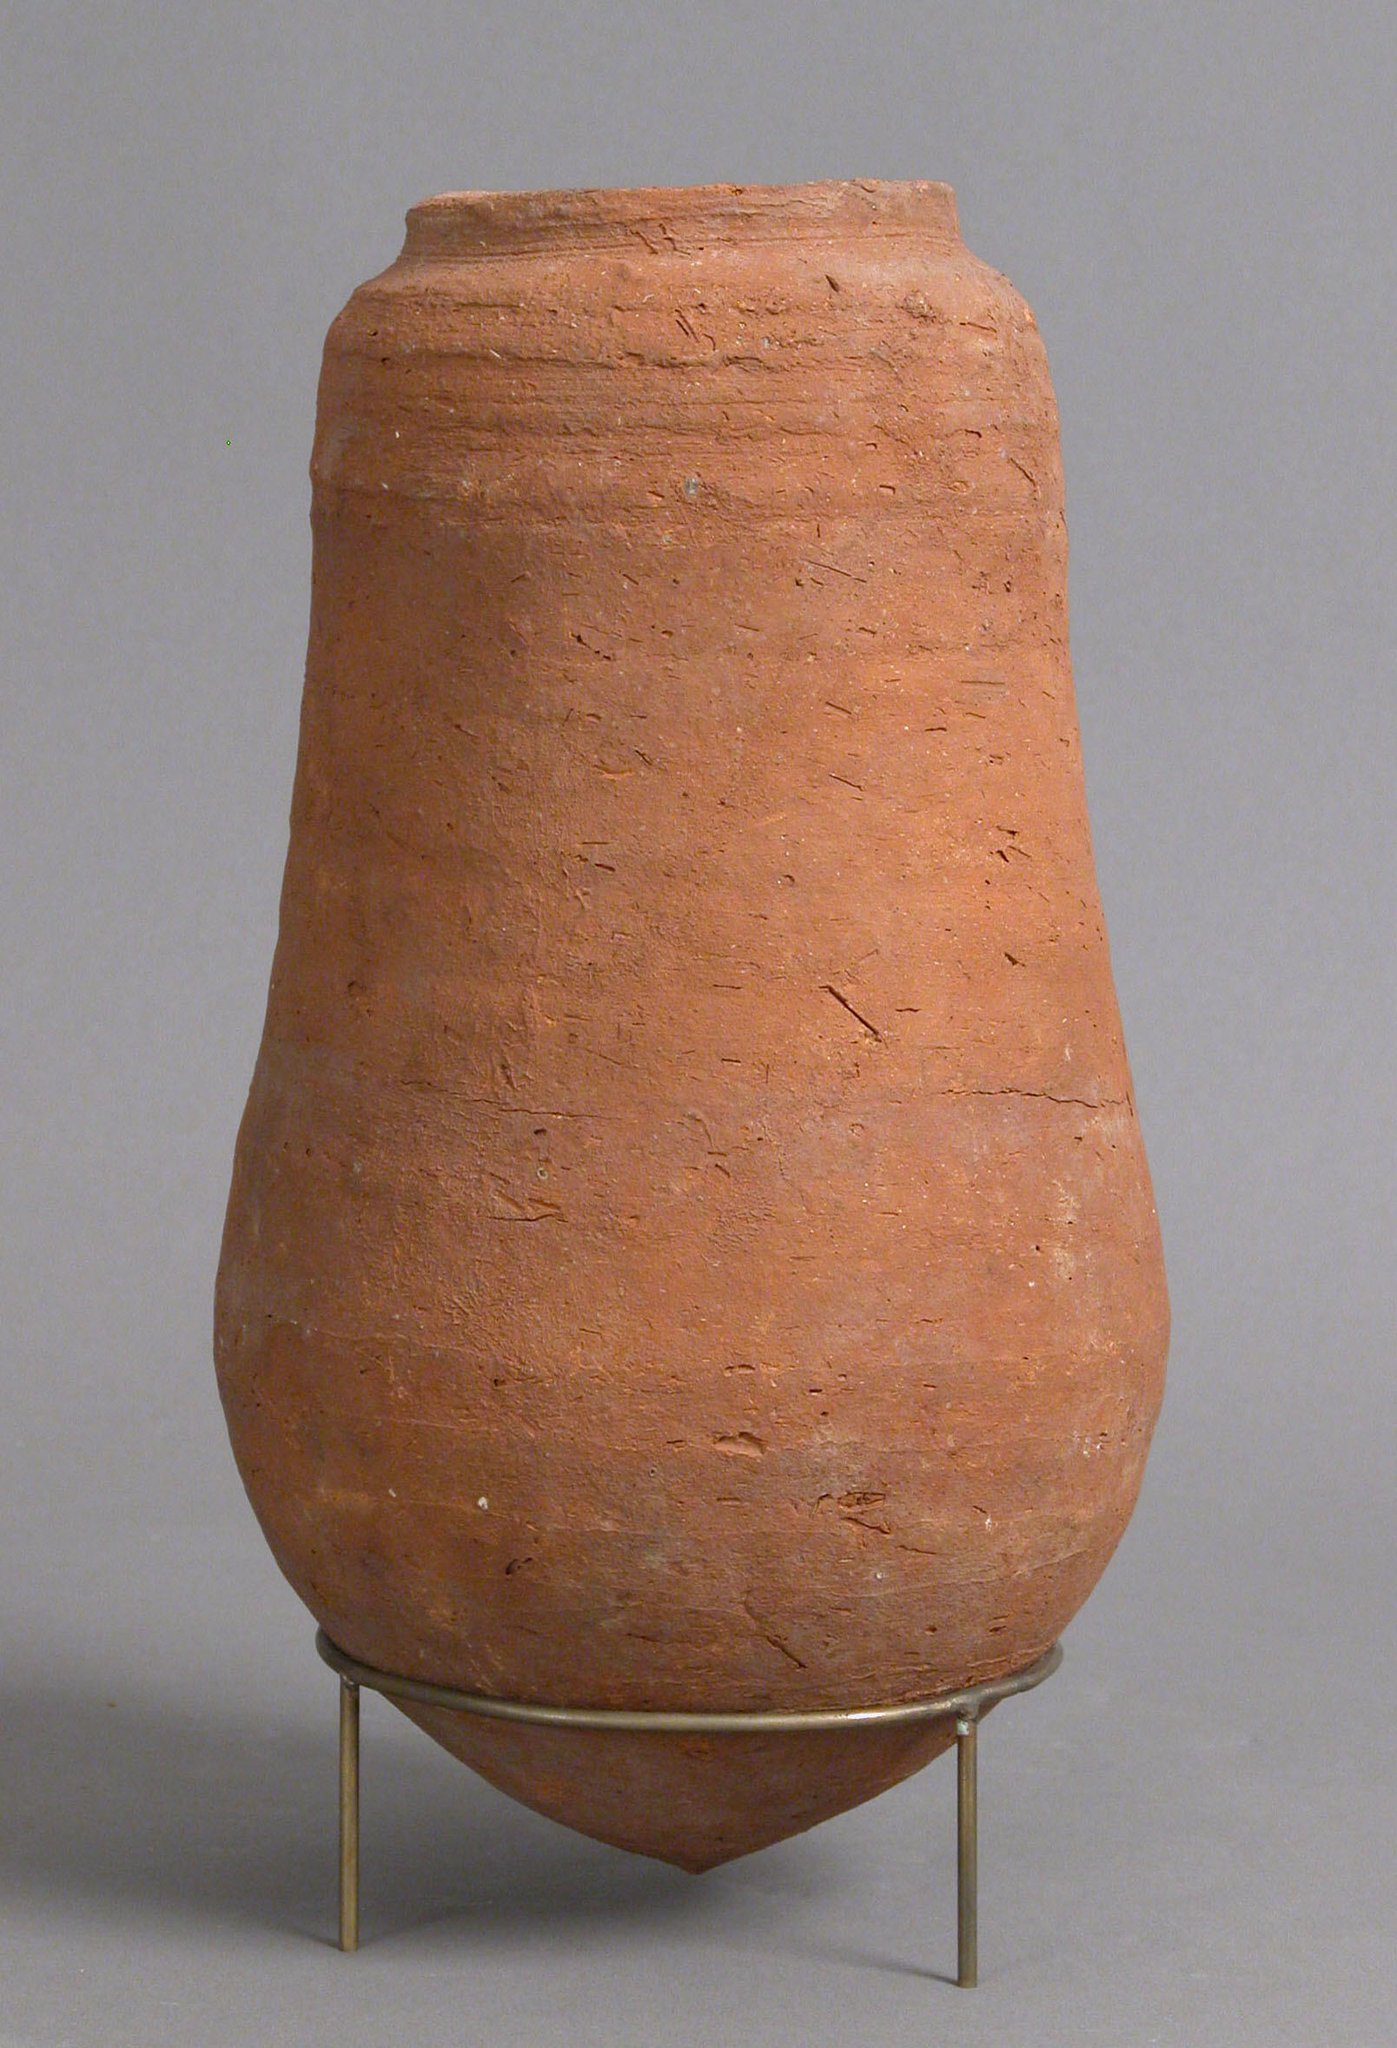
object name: vase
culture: coptic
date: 301-700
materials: earthenware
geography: egypt